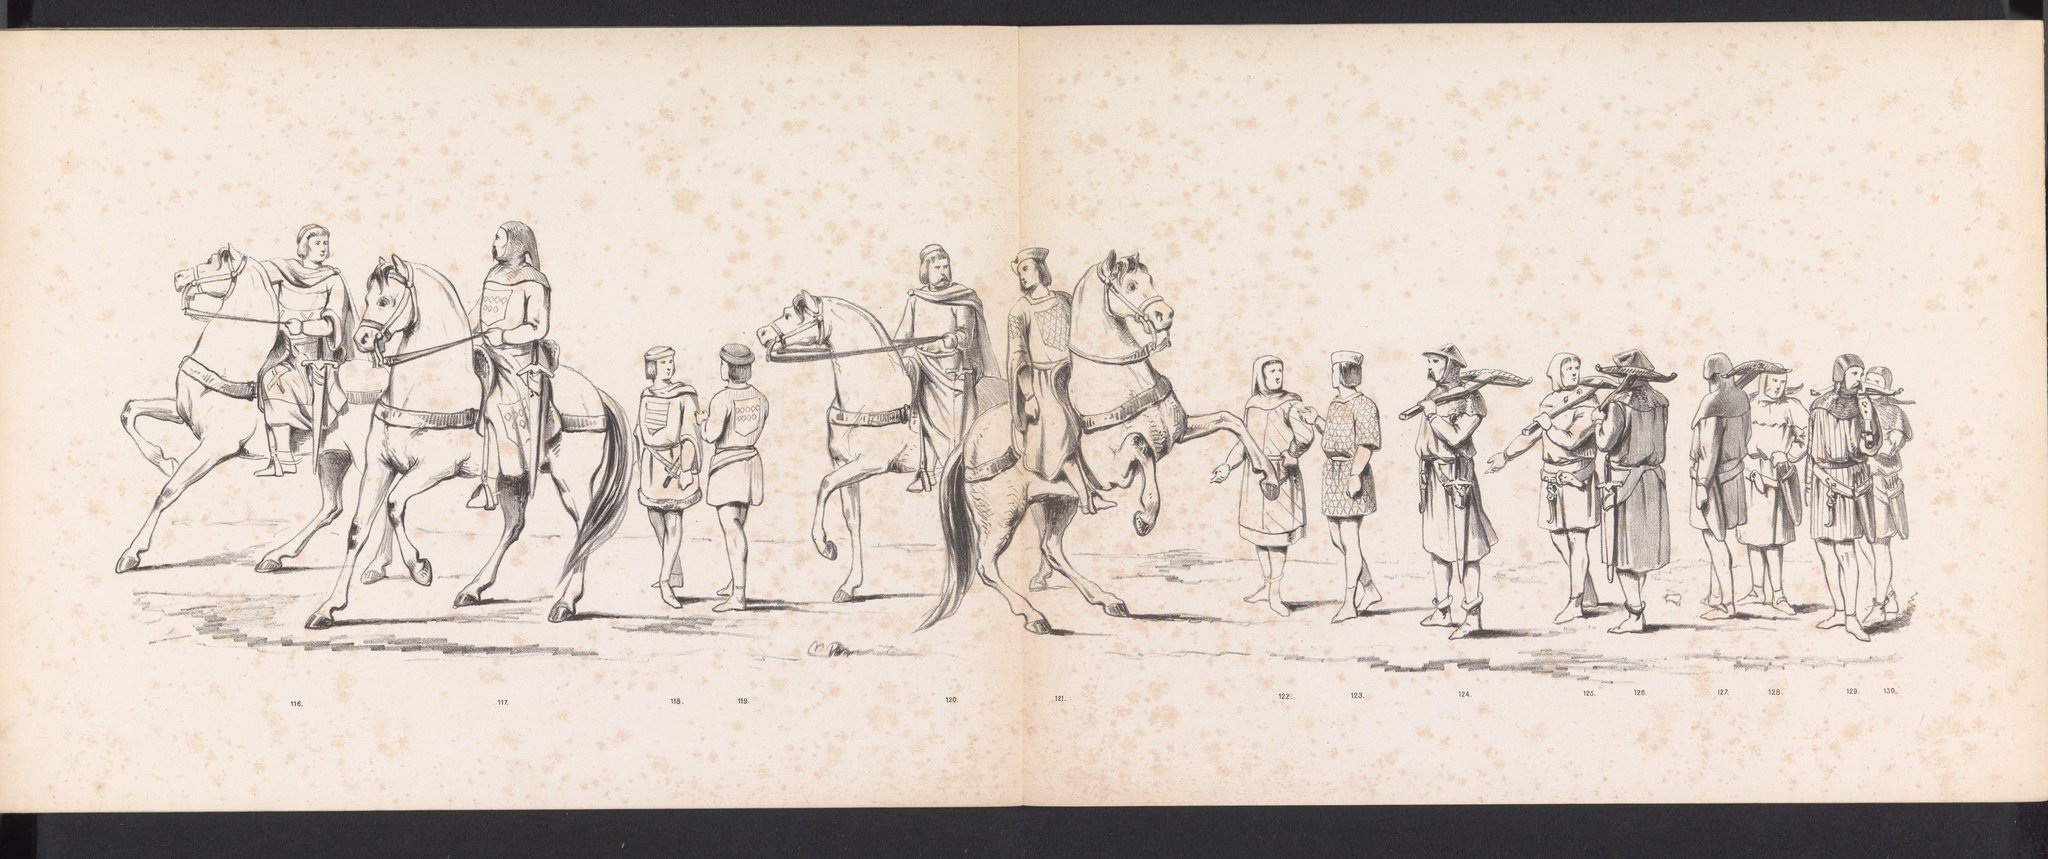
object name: print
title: Maskerade van de Leidse studenten, 1865 (plaat 10)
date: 1865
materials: paper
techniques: lithograph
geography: netherlands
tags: students' pageant, costumes used in pageants, leiden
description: Historische gekostumeerde optocht van de studenten van de Leidse Hogeschool gehouden op 6 juni 1865 ter gelegenheid van het 290-jarig bestaan van de Hogeschool. De optocht verbeeldt de intocht van de Hollanders binnen Zierikzee op 12 augustus 1304. Tiende plaat met de groepen genummerd 116-130. Onderdeel van de serie van 16 aaneen geplakte bladen.